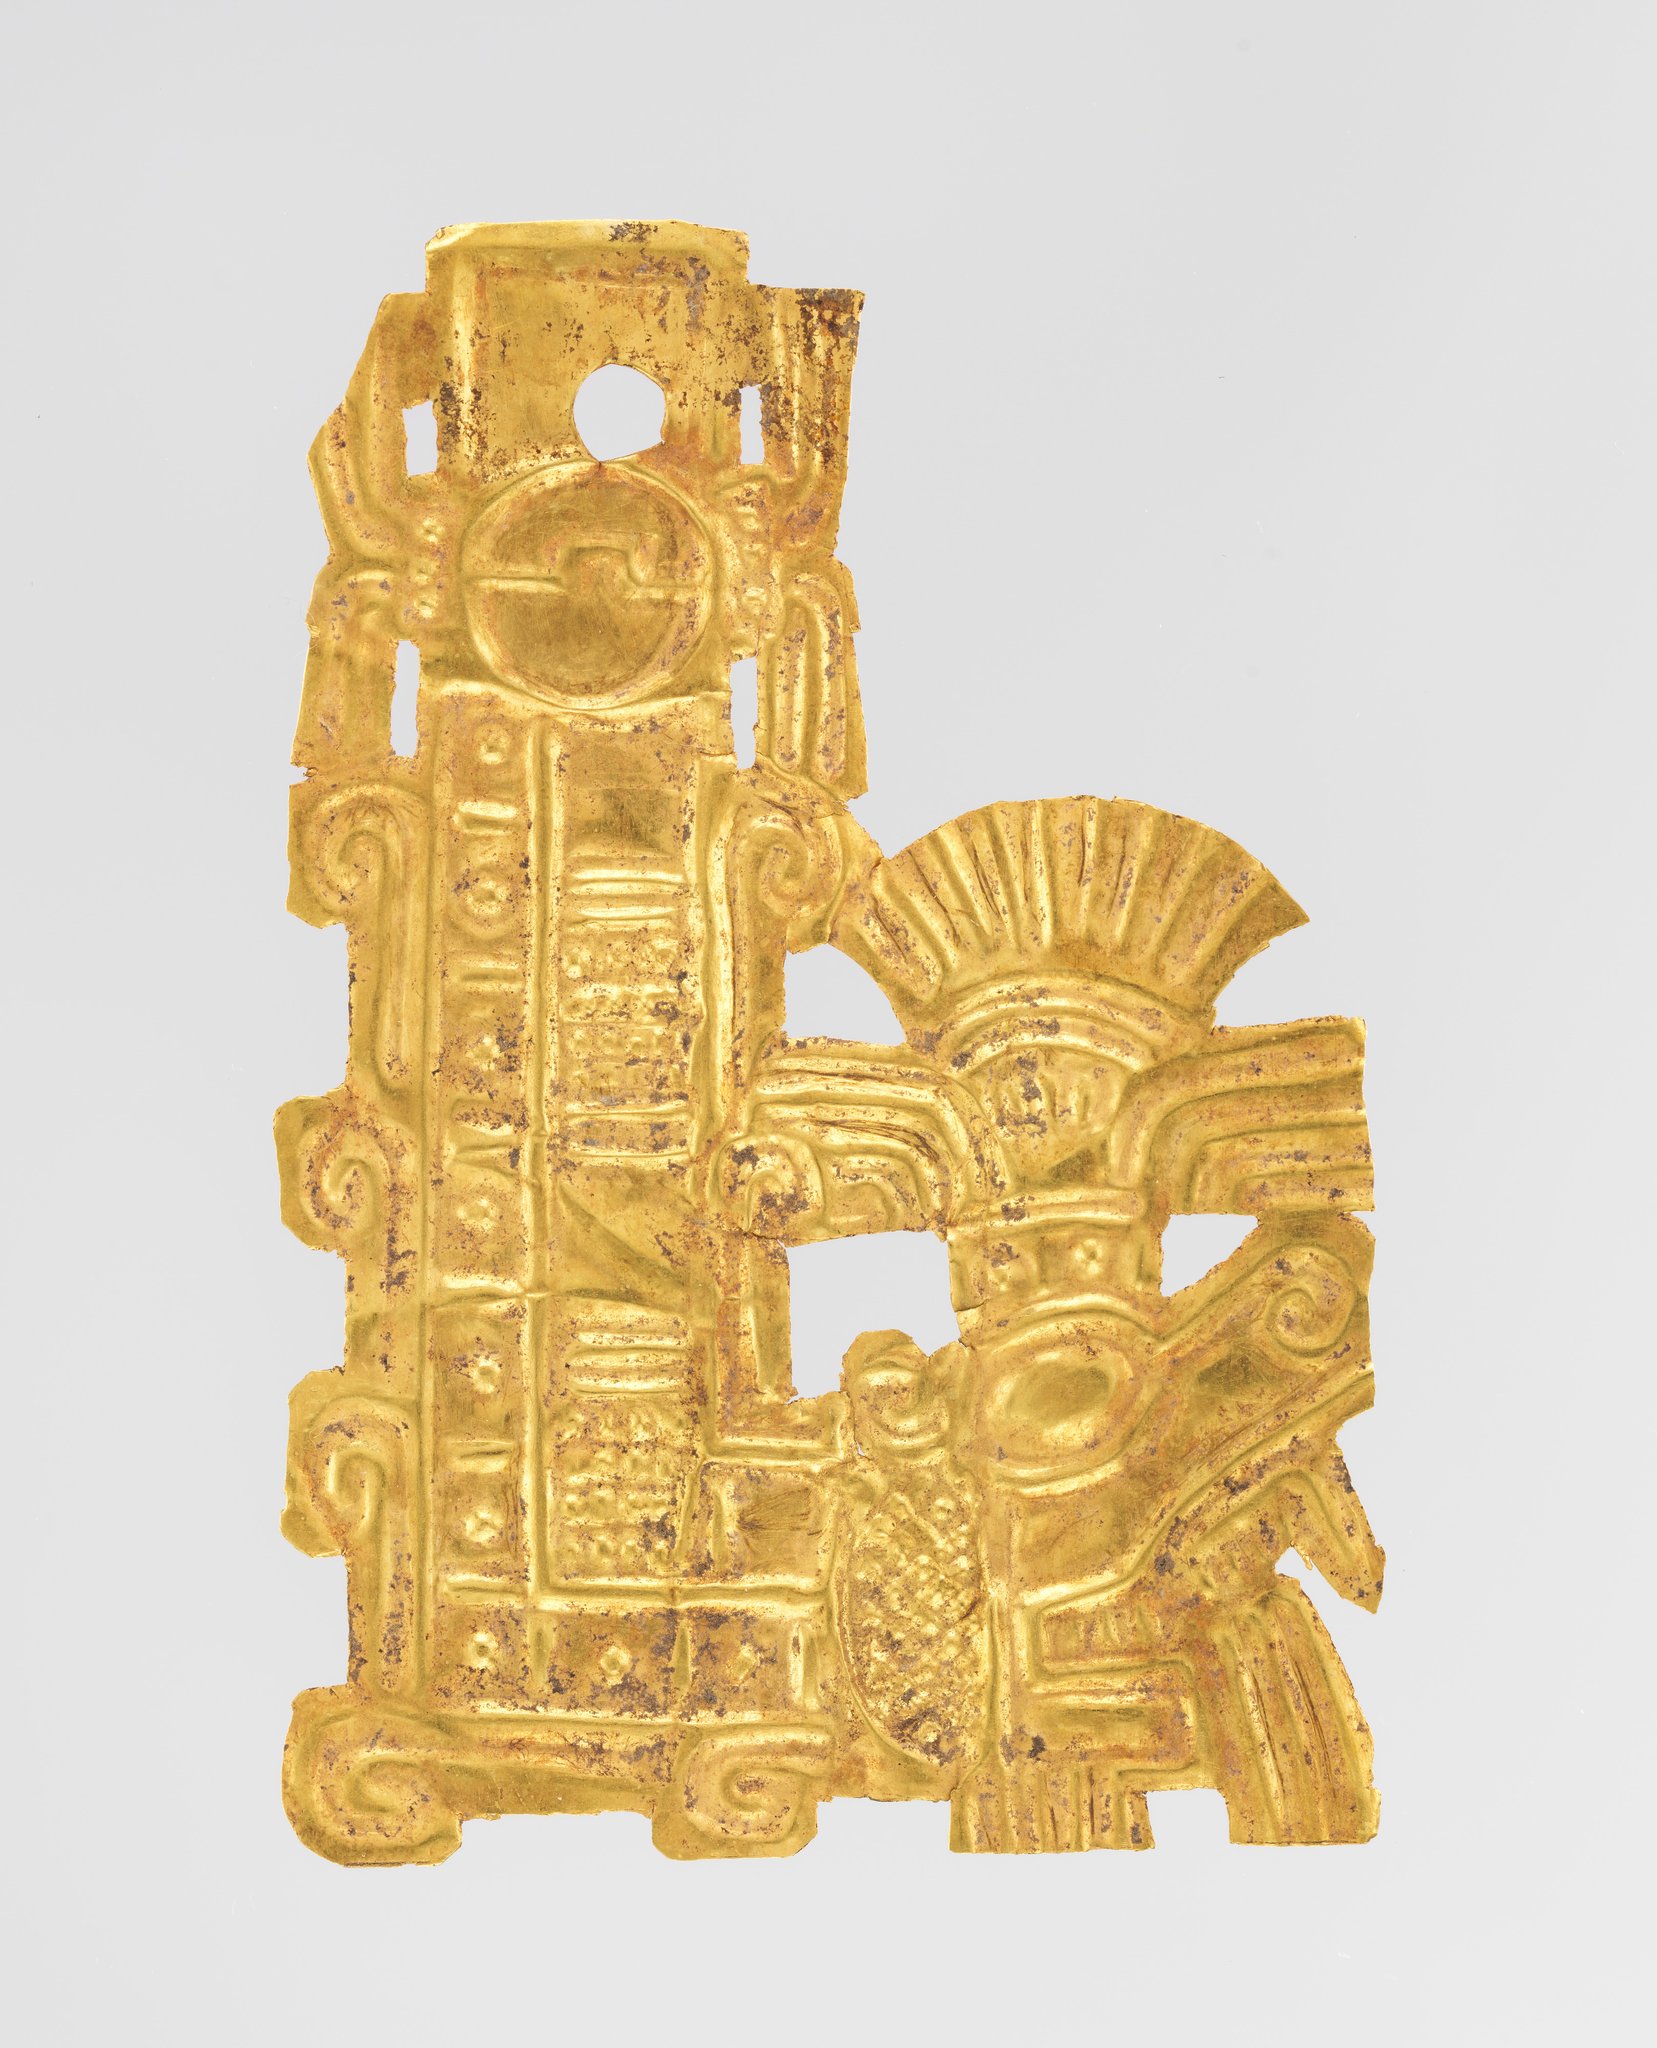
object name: ornament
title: Feathered serpent ornament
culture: mexica, aztec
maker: mexica or mixtec (ñuu savi) artists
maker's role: artist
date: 1325-1521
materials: gold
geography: mexico